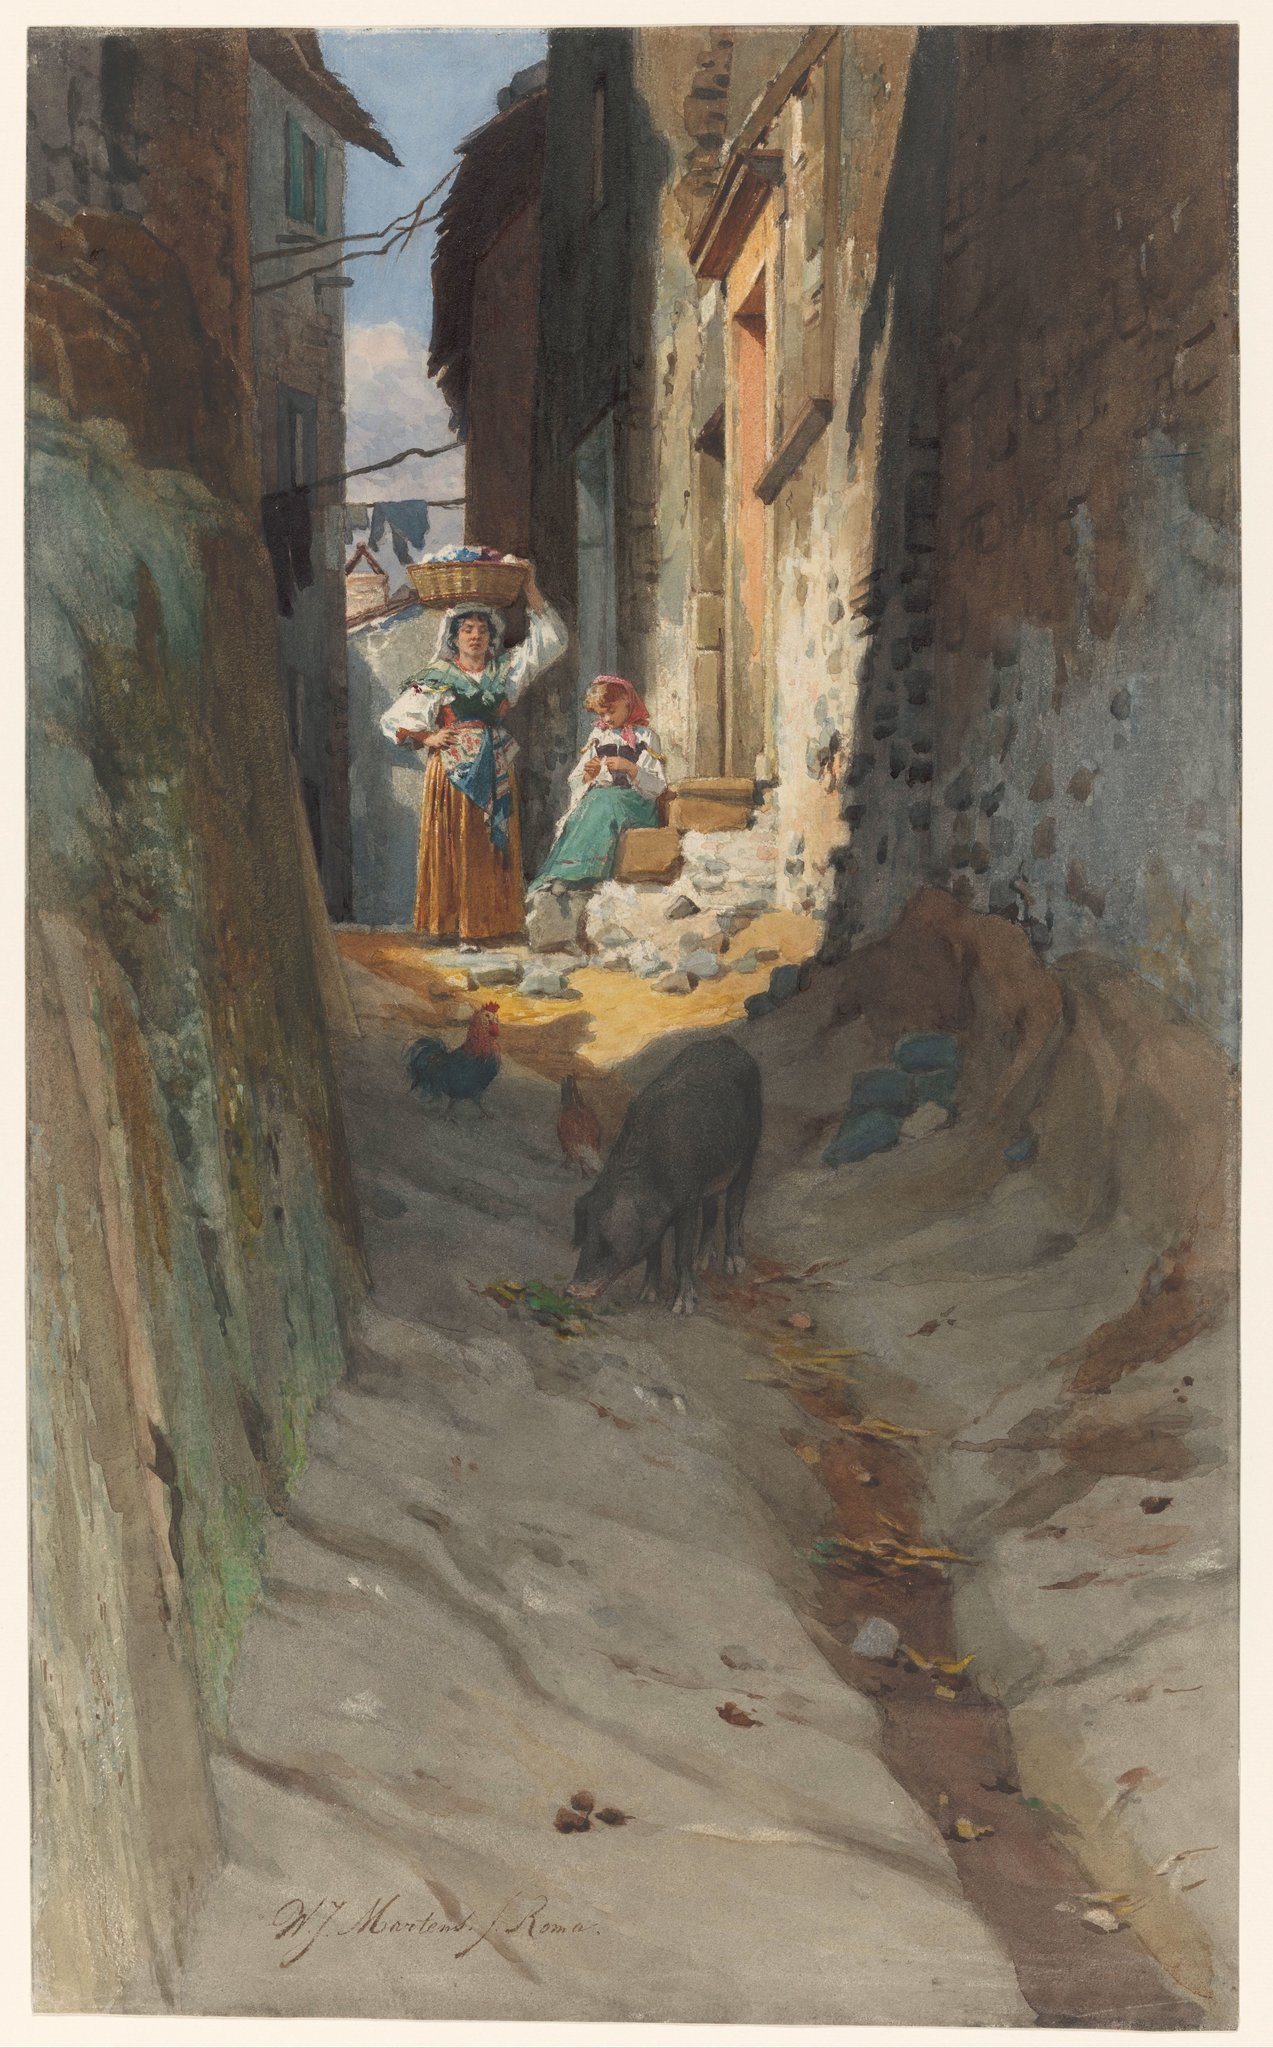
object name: watercolor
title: View of a Small Street in Rocca di Papa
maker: willem johann martens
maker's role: draughtsman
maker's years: 1839-1895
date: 1870-1885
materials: gum arabic, paper, watercolor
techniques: brush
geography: rocca di papa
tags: street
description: Martens was born in Amsterdam and settled in Rome around 1867. His subjects were young, fetching Italian women and genre scenes from Rome and Venice. With the kind of virtuoso execution then prevalent in Italy, he depicted a picturesque street in the town of Rocca di Papa, just south of Rome. At the time, Italian artists hardly ever singled out such subjects.